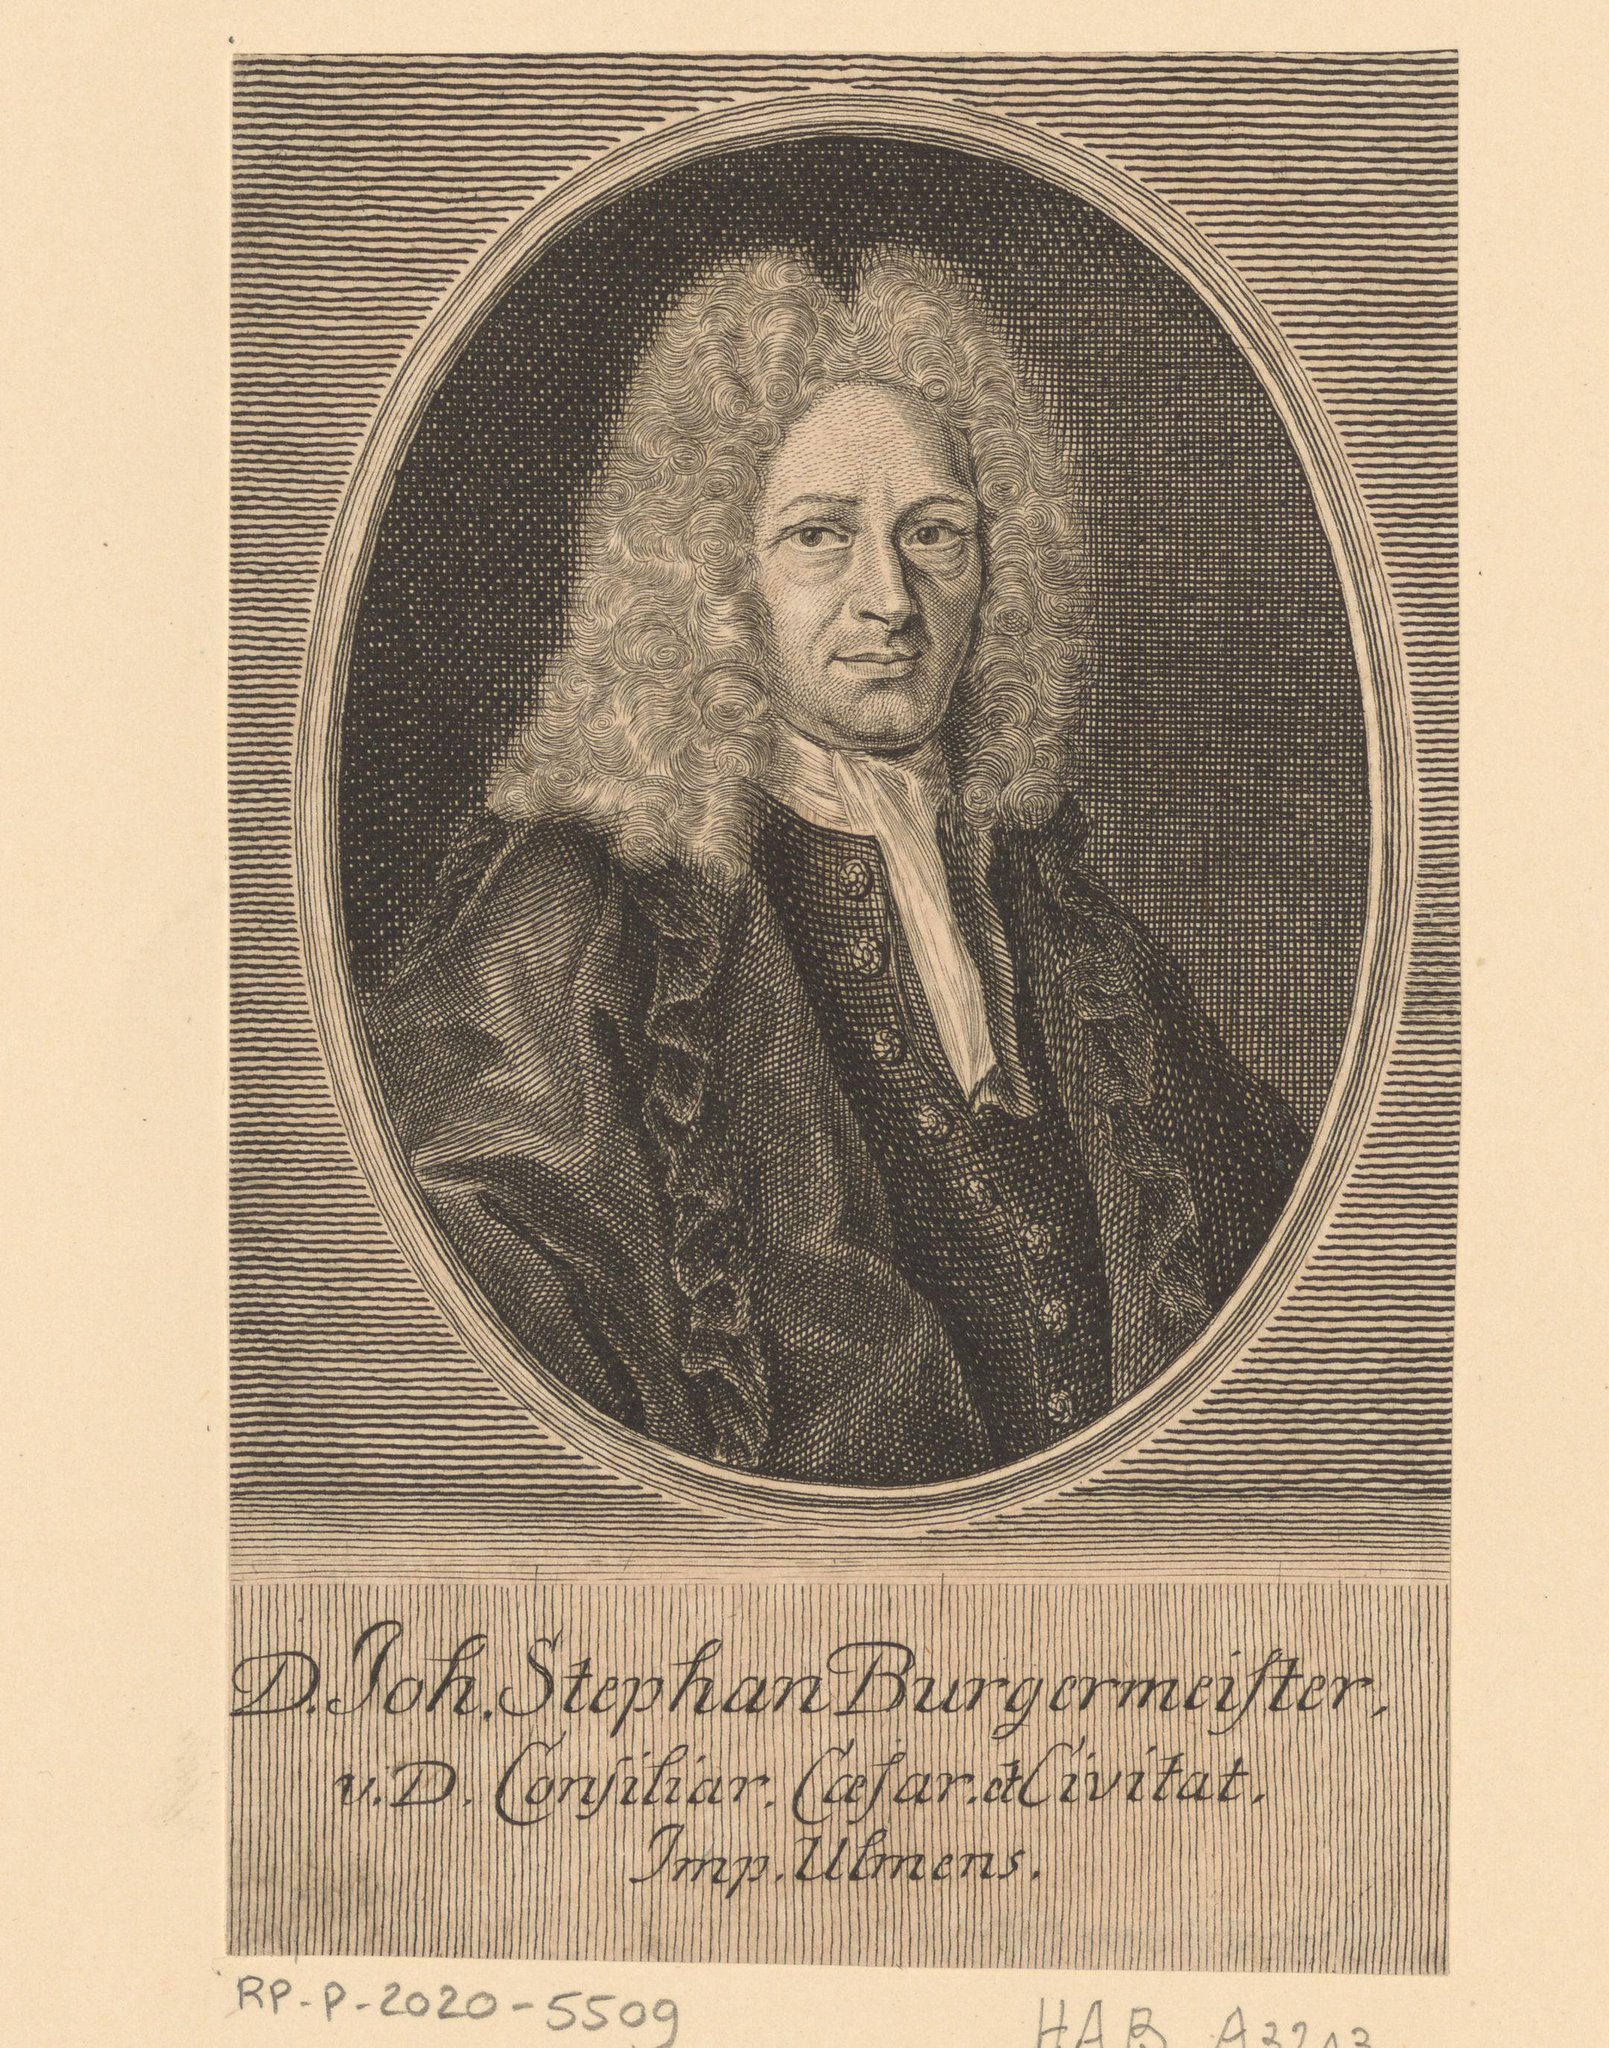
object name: print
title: Portret van Johann Stephan Burgermeister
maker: martin bernigeroth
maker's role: print maker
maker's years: 1670-1733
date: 1700-1733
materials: paper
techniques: engraving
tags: historical persons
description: Prent waarschijnlijk uit: Deutsche Acta Eruditorum. Leipzig: Johann Gottlieb Gleditsch, 1722, dl. 77.